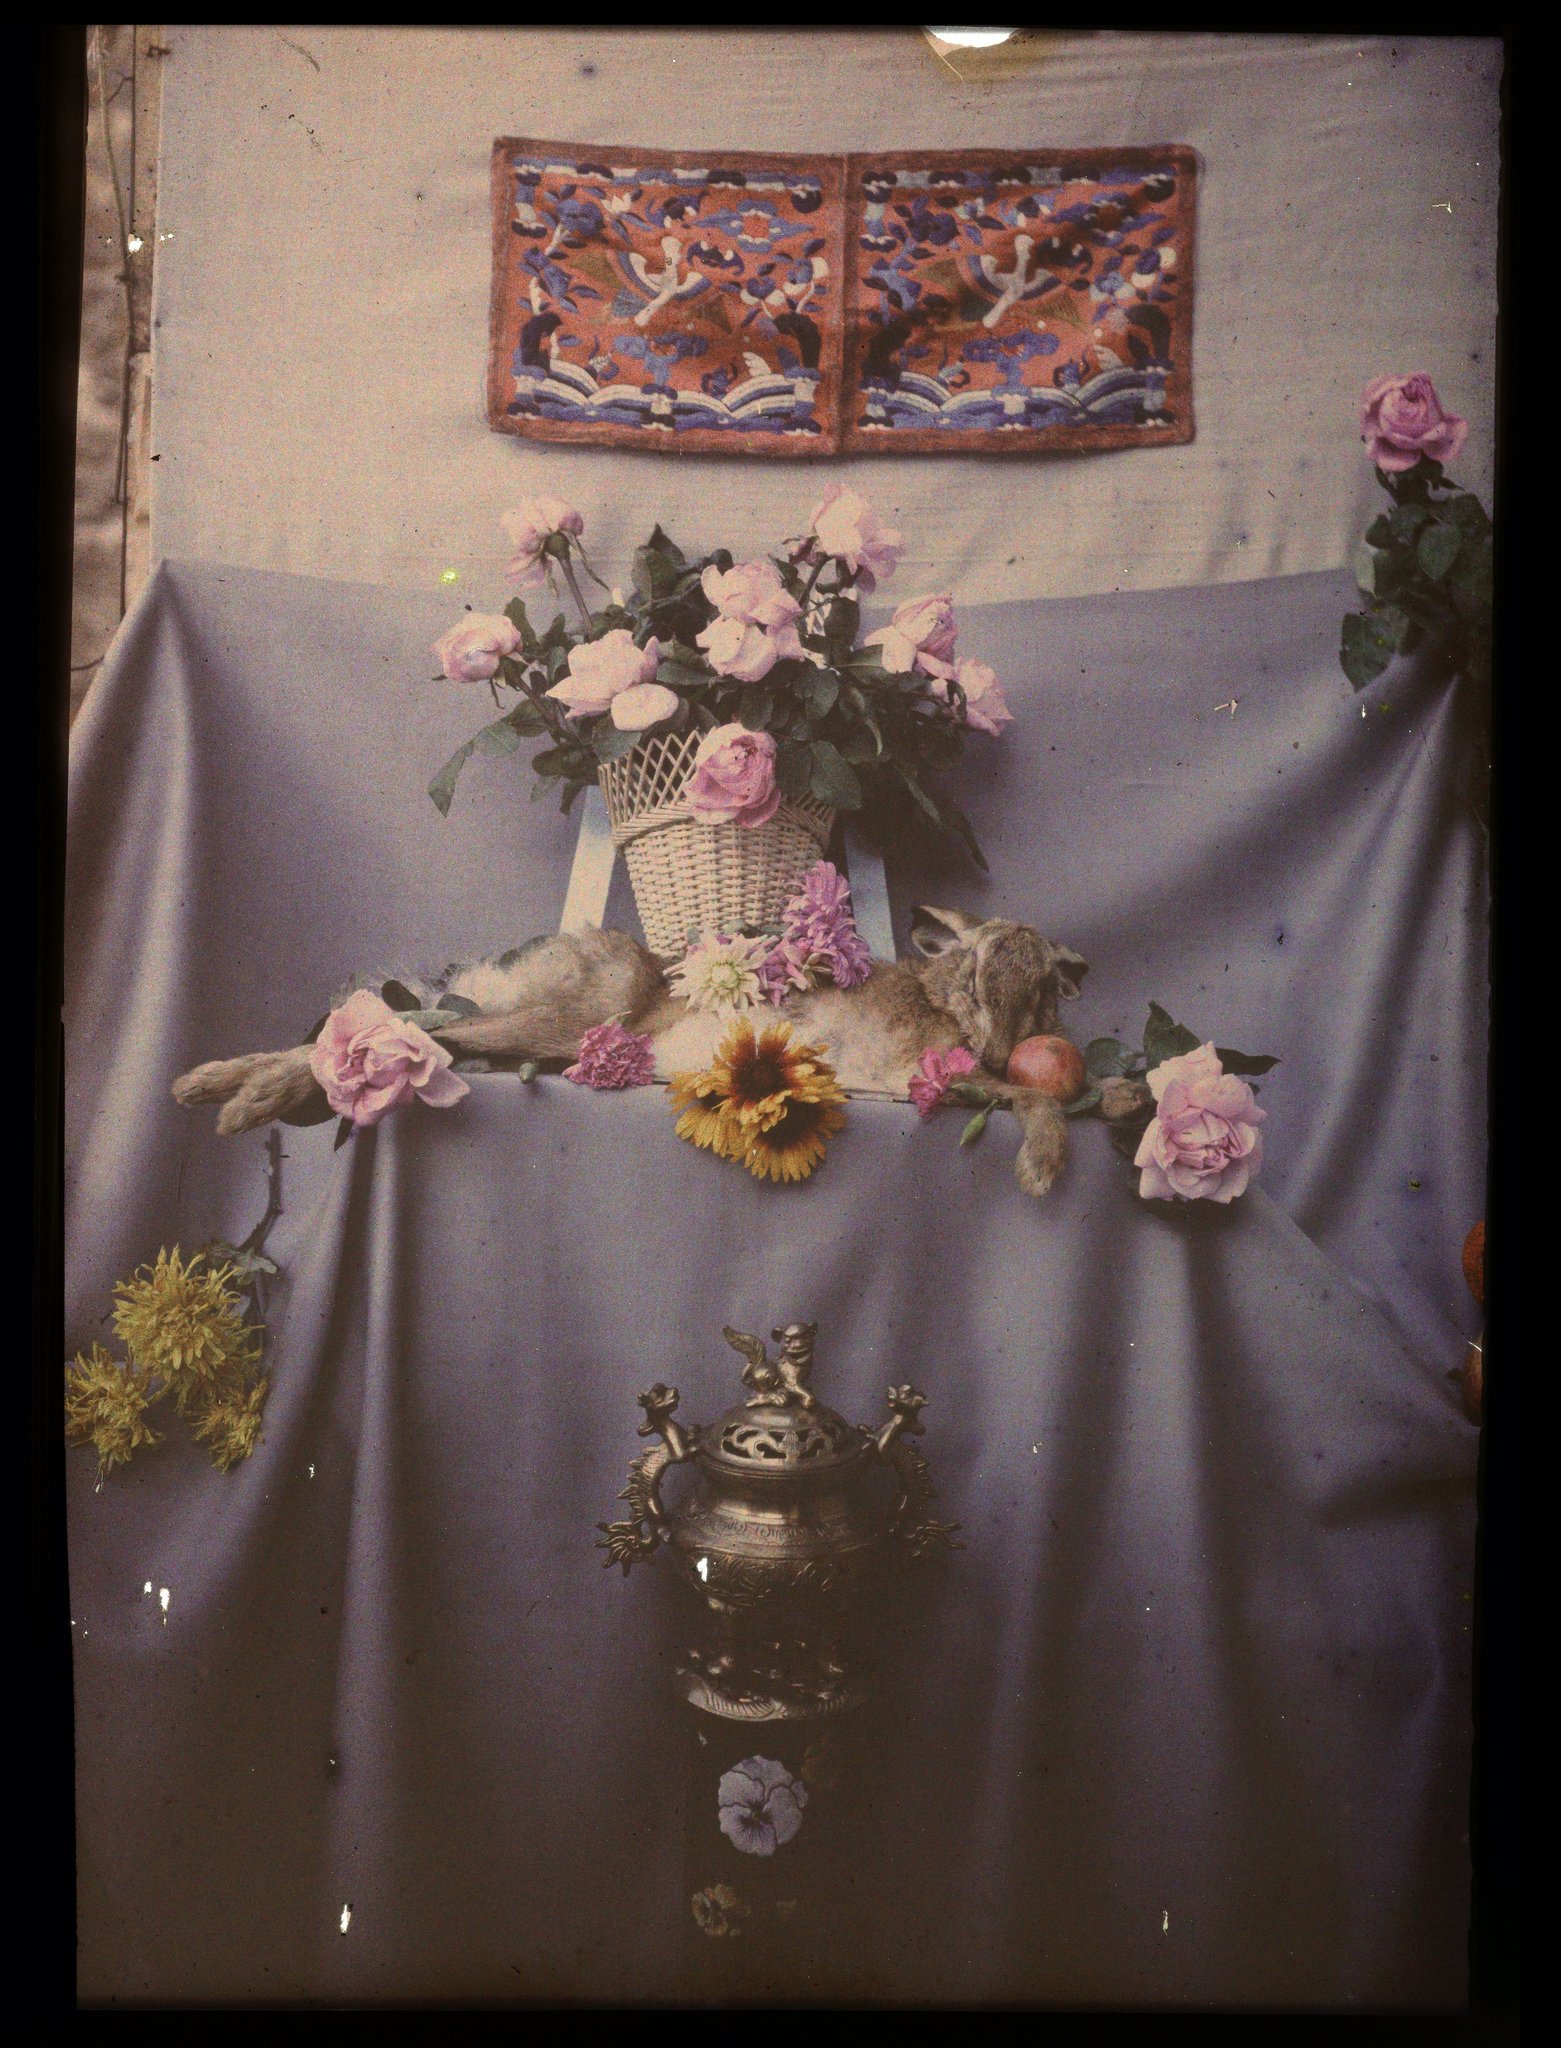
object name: photograph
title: Stilleven met dood wild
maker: Anonymous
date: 1890-1930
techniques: autochrome process, slide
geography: france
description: Stilleven met rozen en dood konijn op tafel.